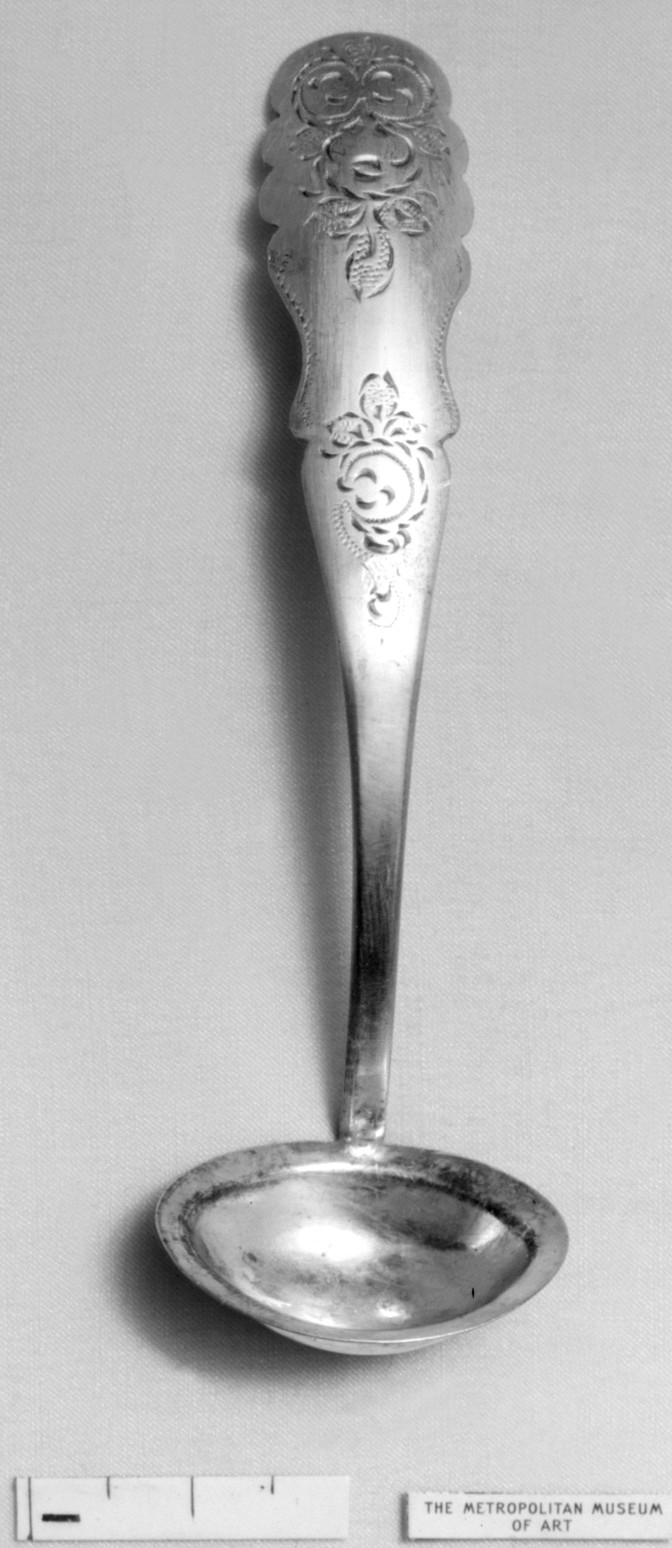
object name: mustard spoon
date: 1801-1850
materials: silver